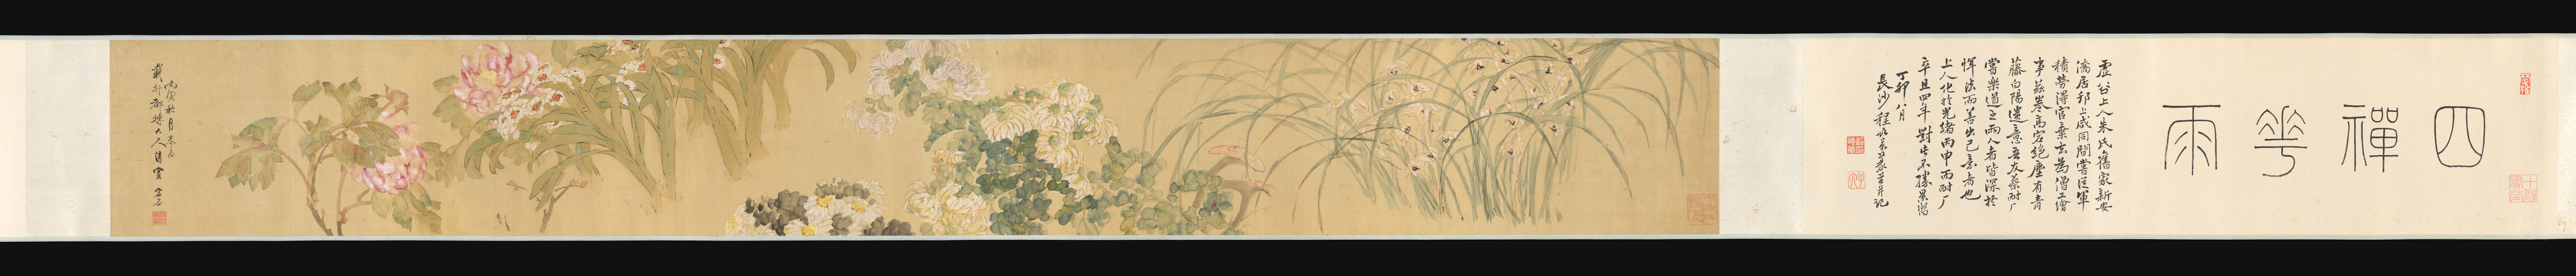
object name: handscroll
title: Flowers in Rain through the Four Stages of Meditation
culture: chinese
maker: xugu (zhu huairen)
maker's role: artist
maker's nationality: chinese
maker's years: 1823-1896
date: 1866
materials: ink, silk